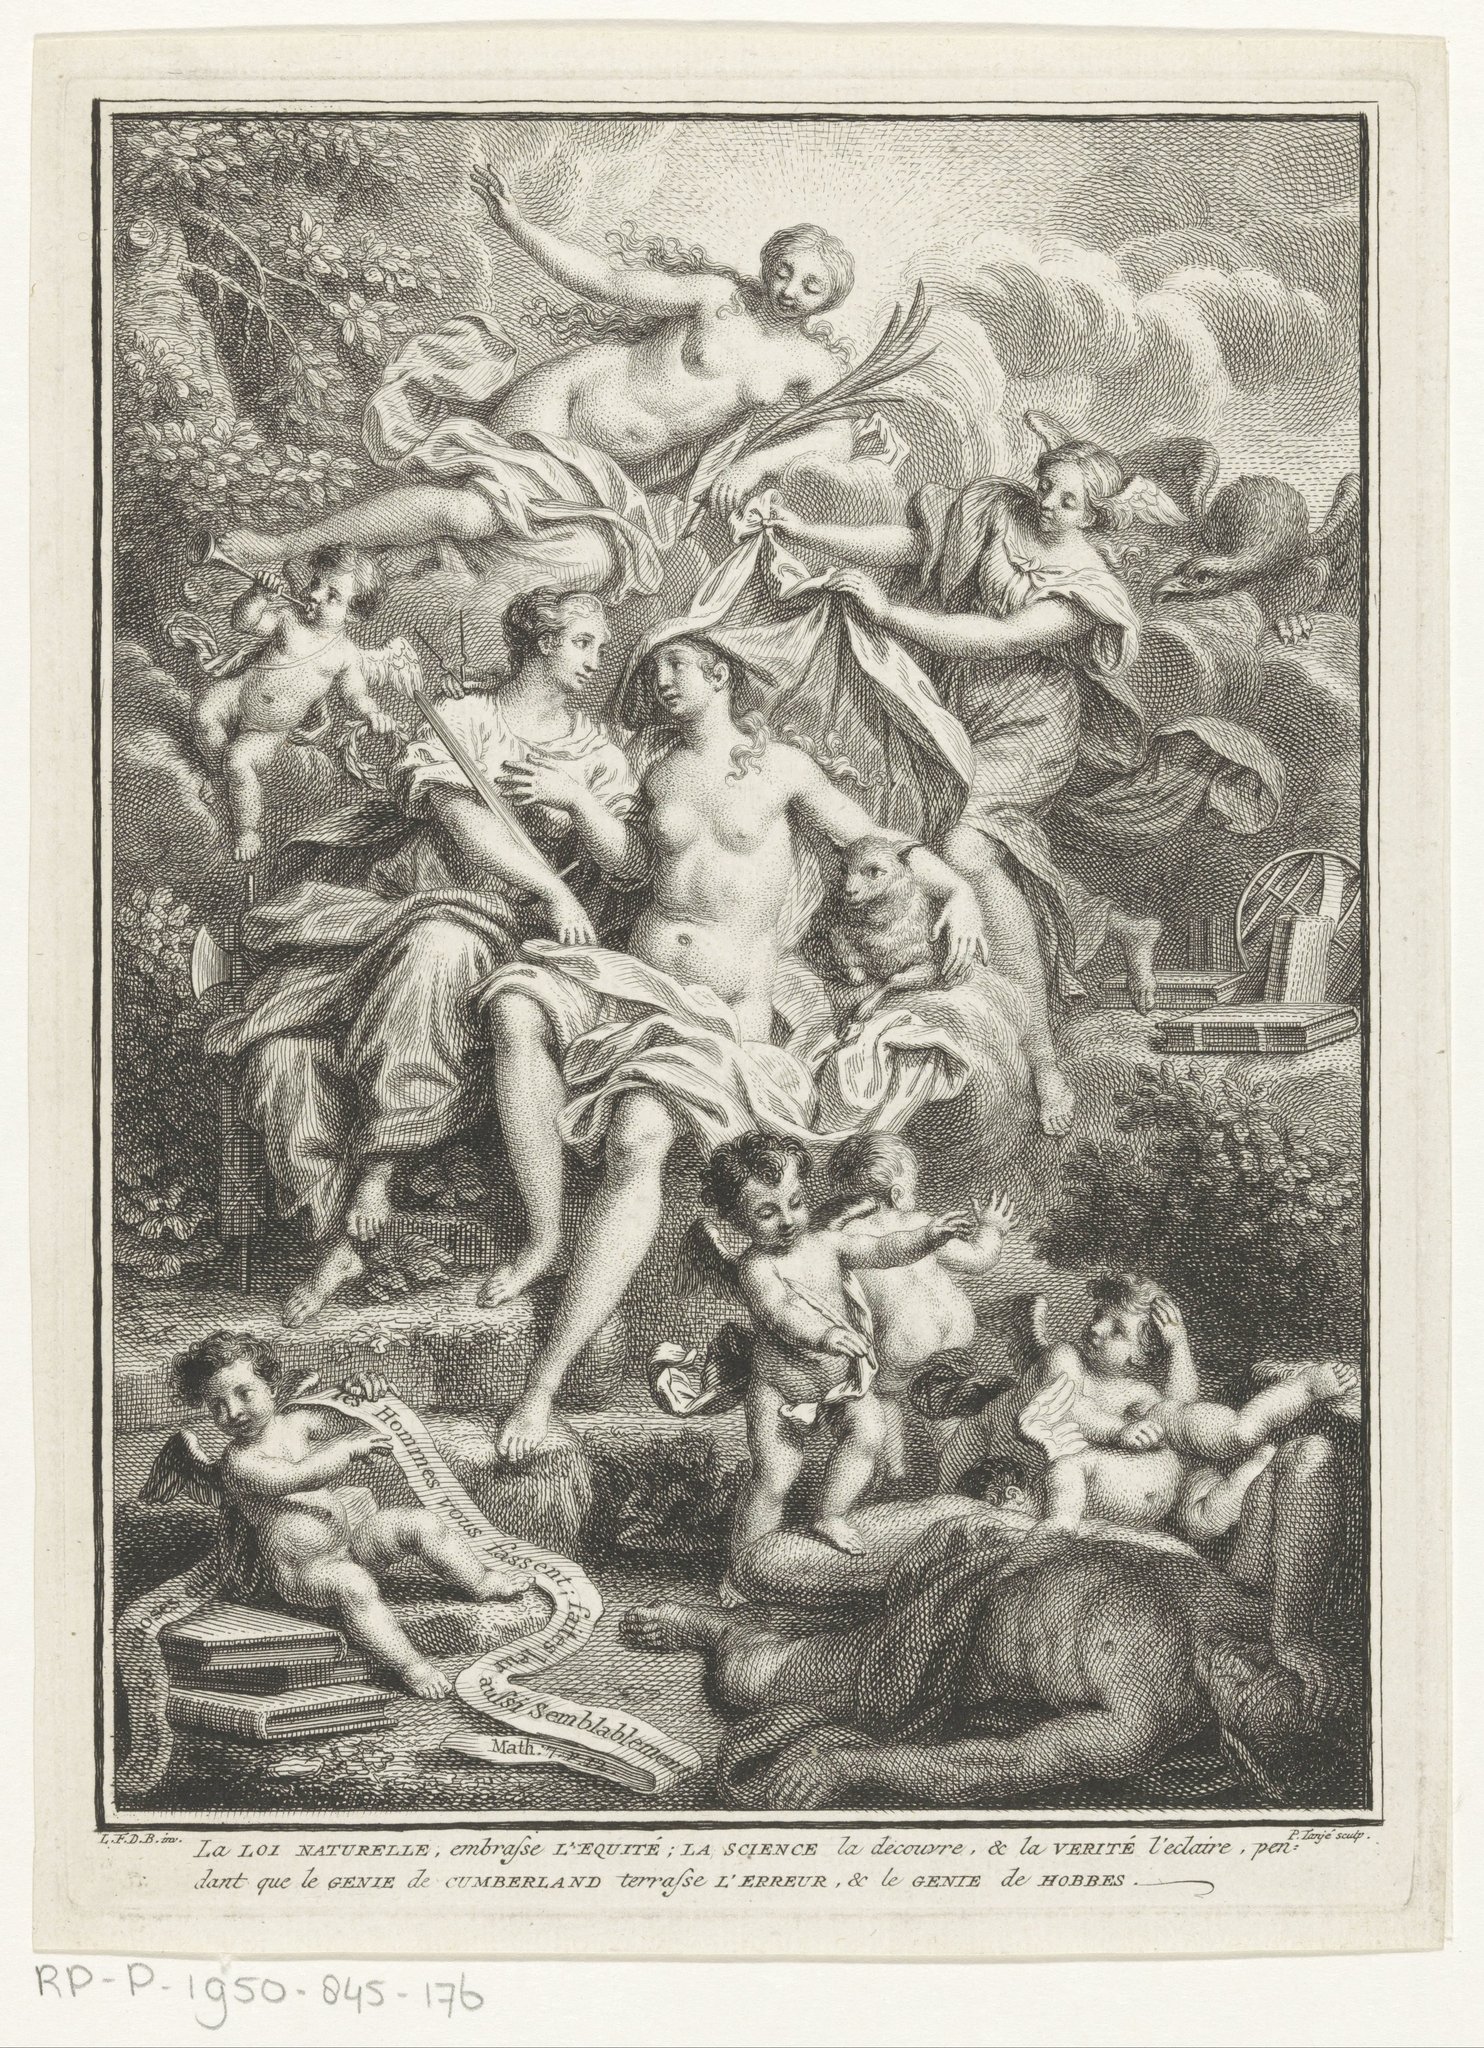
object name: titelblad, titelpagina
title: Natuurlijke Wet ontsluierd door Wetenschap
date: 1744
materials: paper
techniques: etching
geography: amsterdam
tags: 'natura' (allegorical figure or scene; or as diana of ephesus, with many breasts); 'natura' (ripa), symbolic representations, allegories and emblems ~ science, 'scientia'; 'scienza', 'studio' (ripa), truth; 'verità' (ripa), error; 'errore' (ripa), equality, equity, fairness, righteousness; 'equalità', 'equità', 'giuditio giusto', 'ordine dritto e giusto', 'ugualità' (ripa)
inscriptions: collector's mark: Lugt 2760, collector's mark: Lugt 2228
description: Titelpagina voor een boek van Richard Cumberland, waarin hij de ideeën van Thomas Hobbes bestrijdt. De Wet van de Natuur, in de persoon van Venus, omarmt het Gelijk. Zij houdt een zwaard in de hand. De Wet van de natuur wordt door Wetenschap ontsluierd en door Waarheid verlicht. Putti, die het genie van de schrijver Richard Cumberland personifiëren, overwinnen de Fout van Thomas Hobbes, die op de grond ligt. In de ondermarge een tweeregelige Franse tekst.